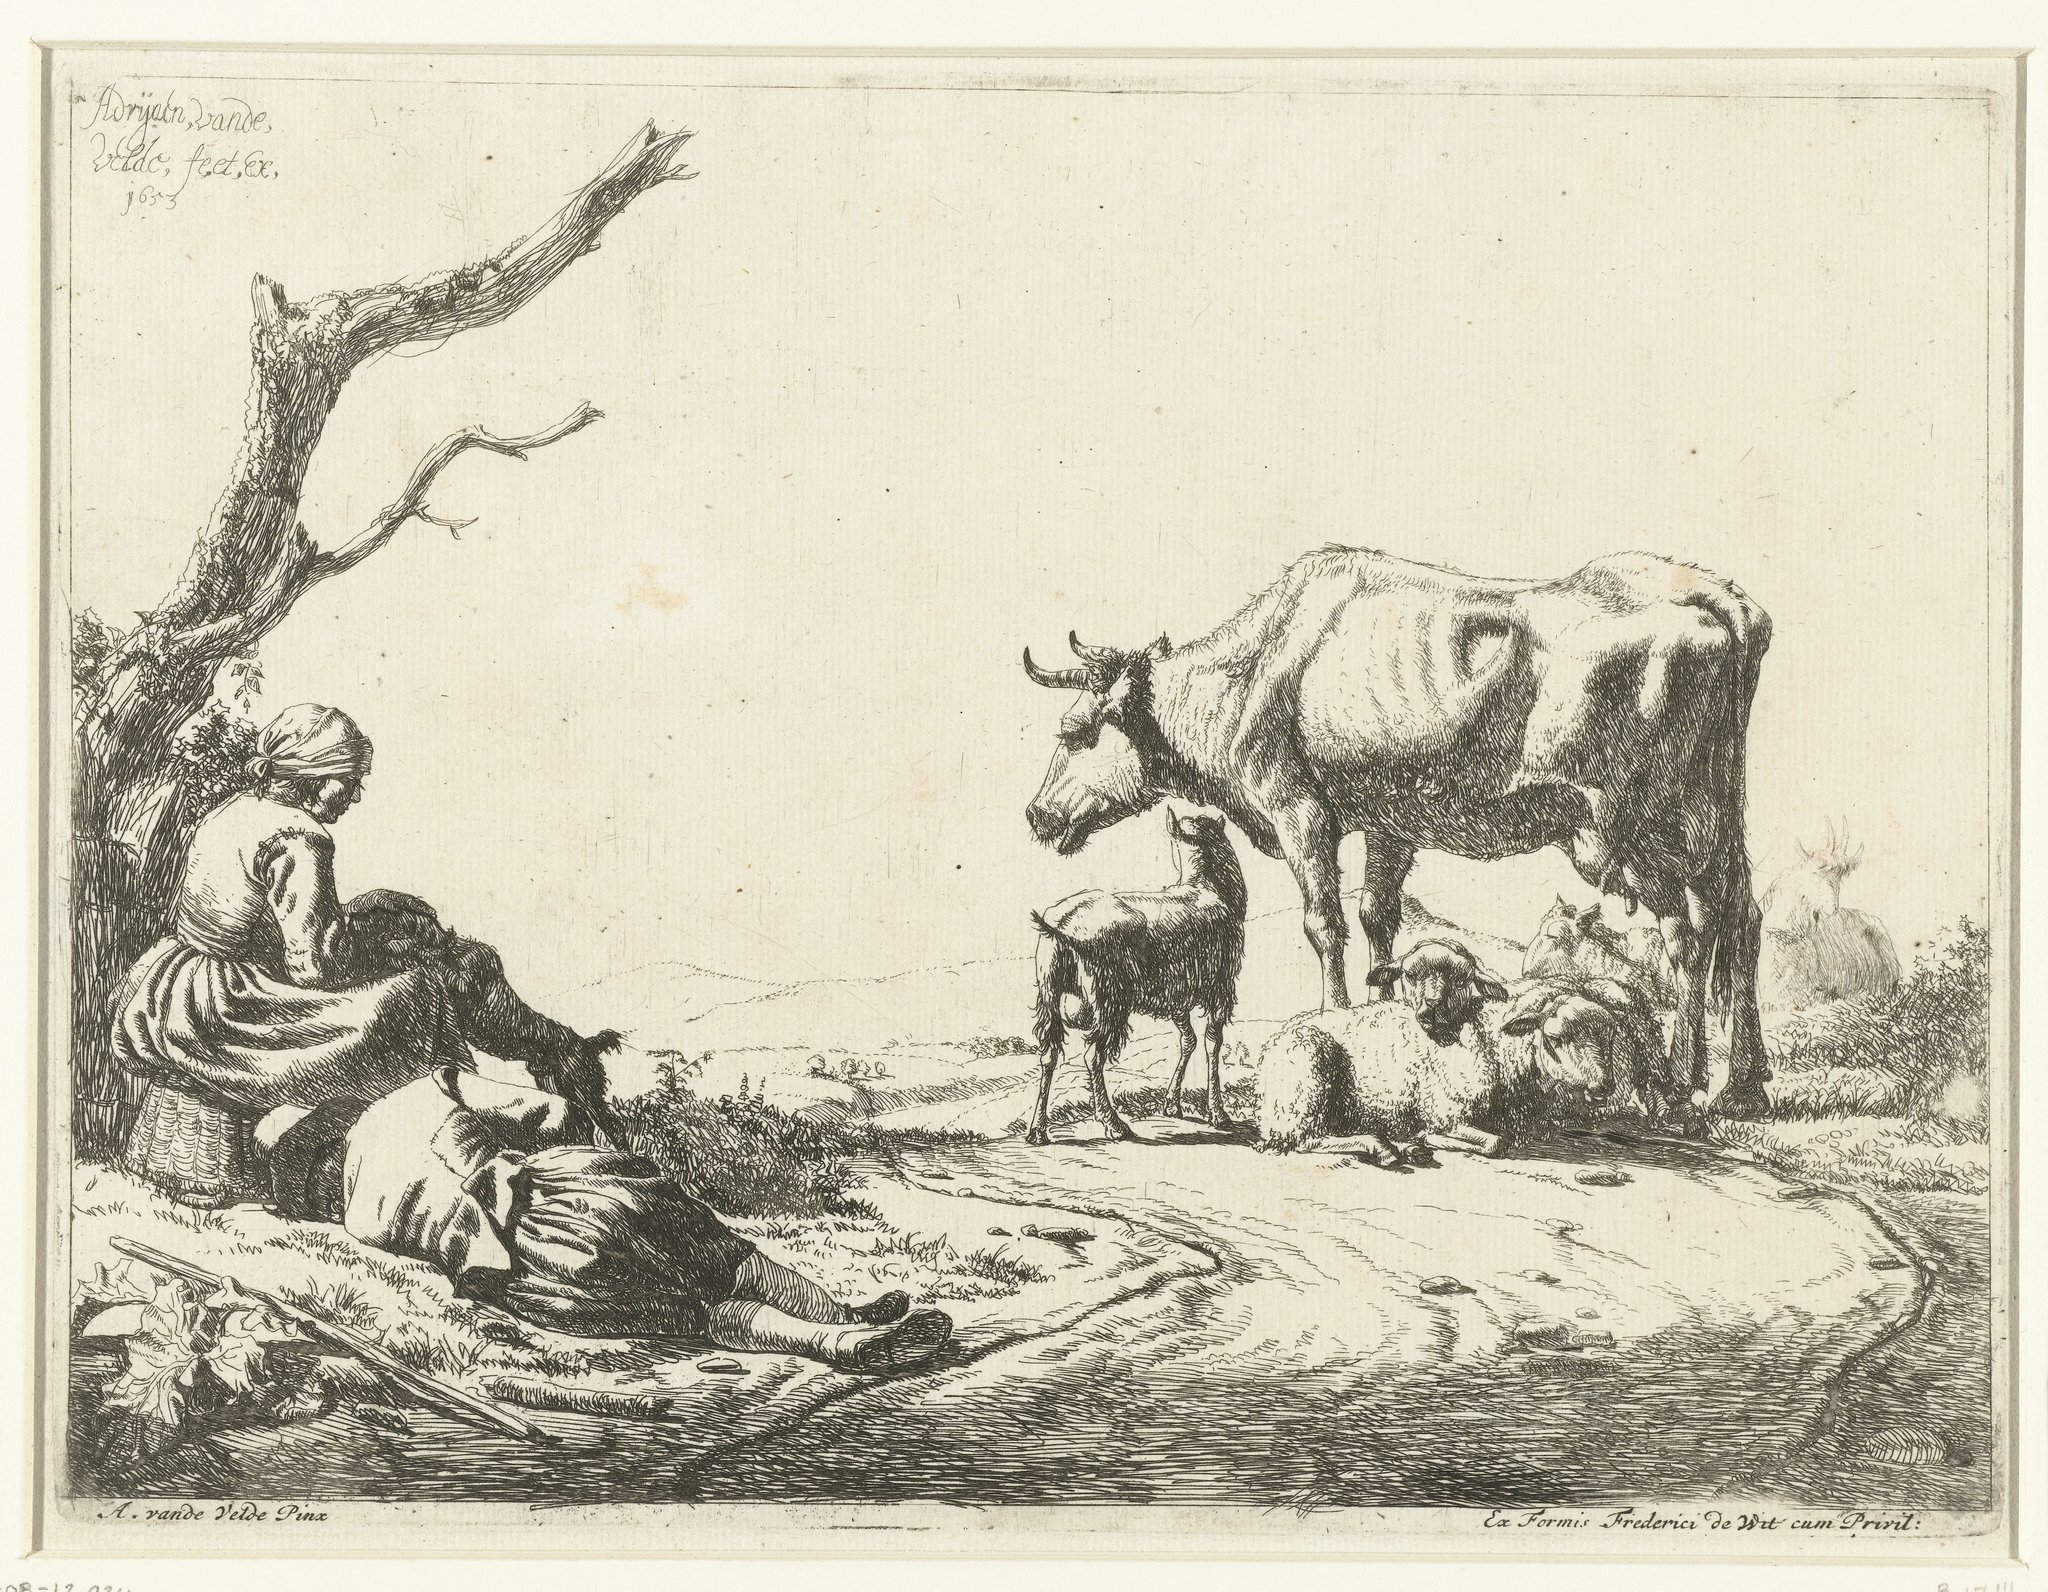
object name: print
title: Herder en herderin met vee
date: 1653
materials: paper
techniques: engraving, etching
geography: amsterdam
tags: cow, herding, herdsman, herdswoman, shepherd, shepherdess, cowherd, etc., sheep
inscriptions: collector's mark: Lugt 240